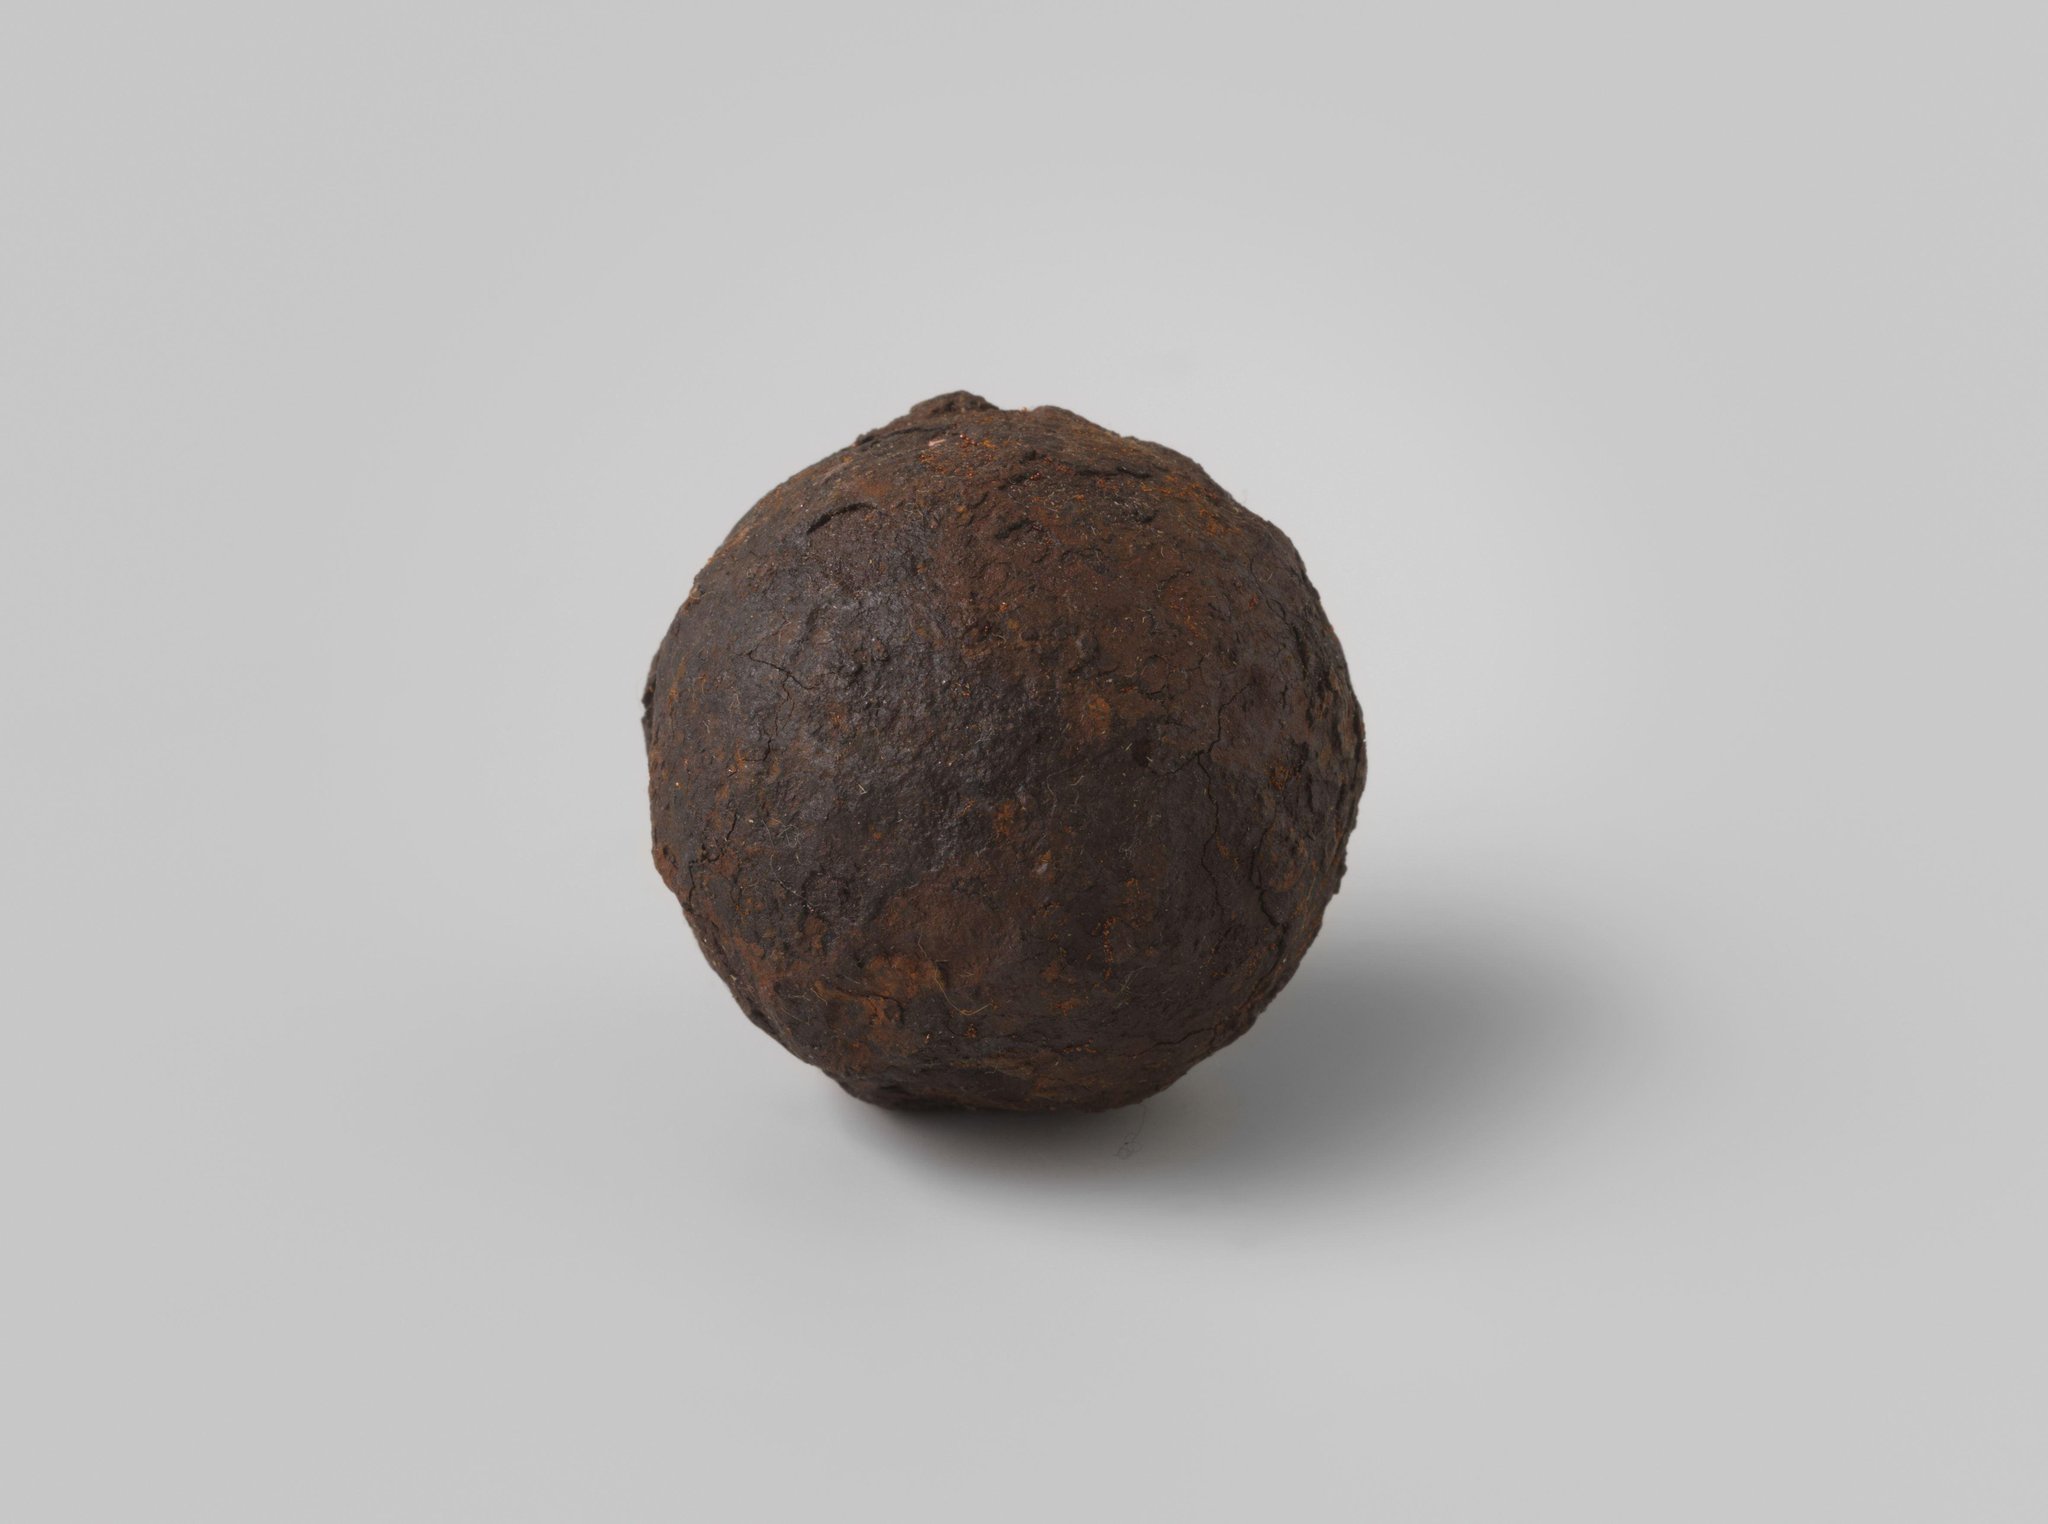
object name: bullet ammunition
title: Kogel uit het wrak van de Oost-Indiëvaarder Hollandia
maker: Anonymous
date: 1700-1743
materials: iron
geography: netherlands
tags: verenigde oostindische compagnie, hollandia (schip), annet